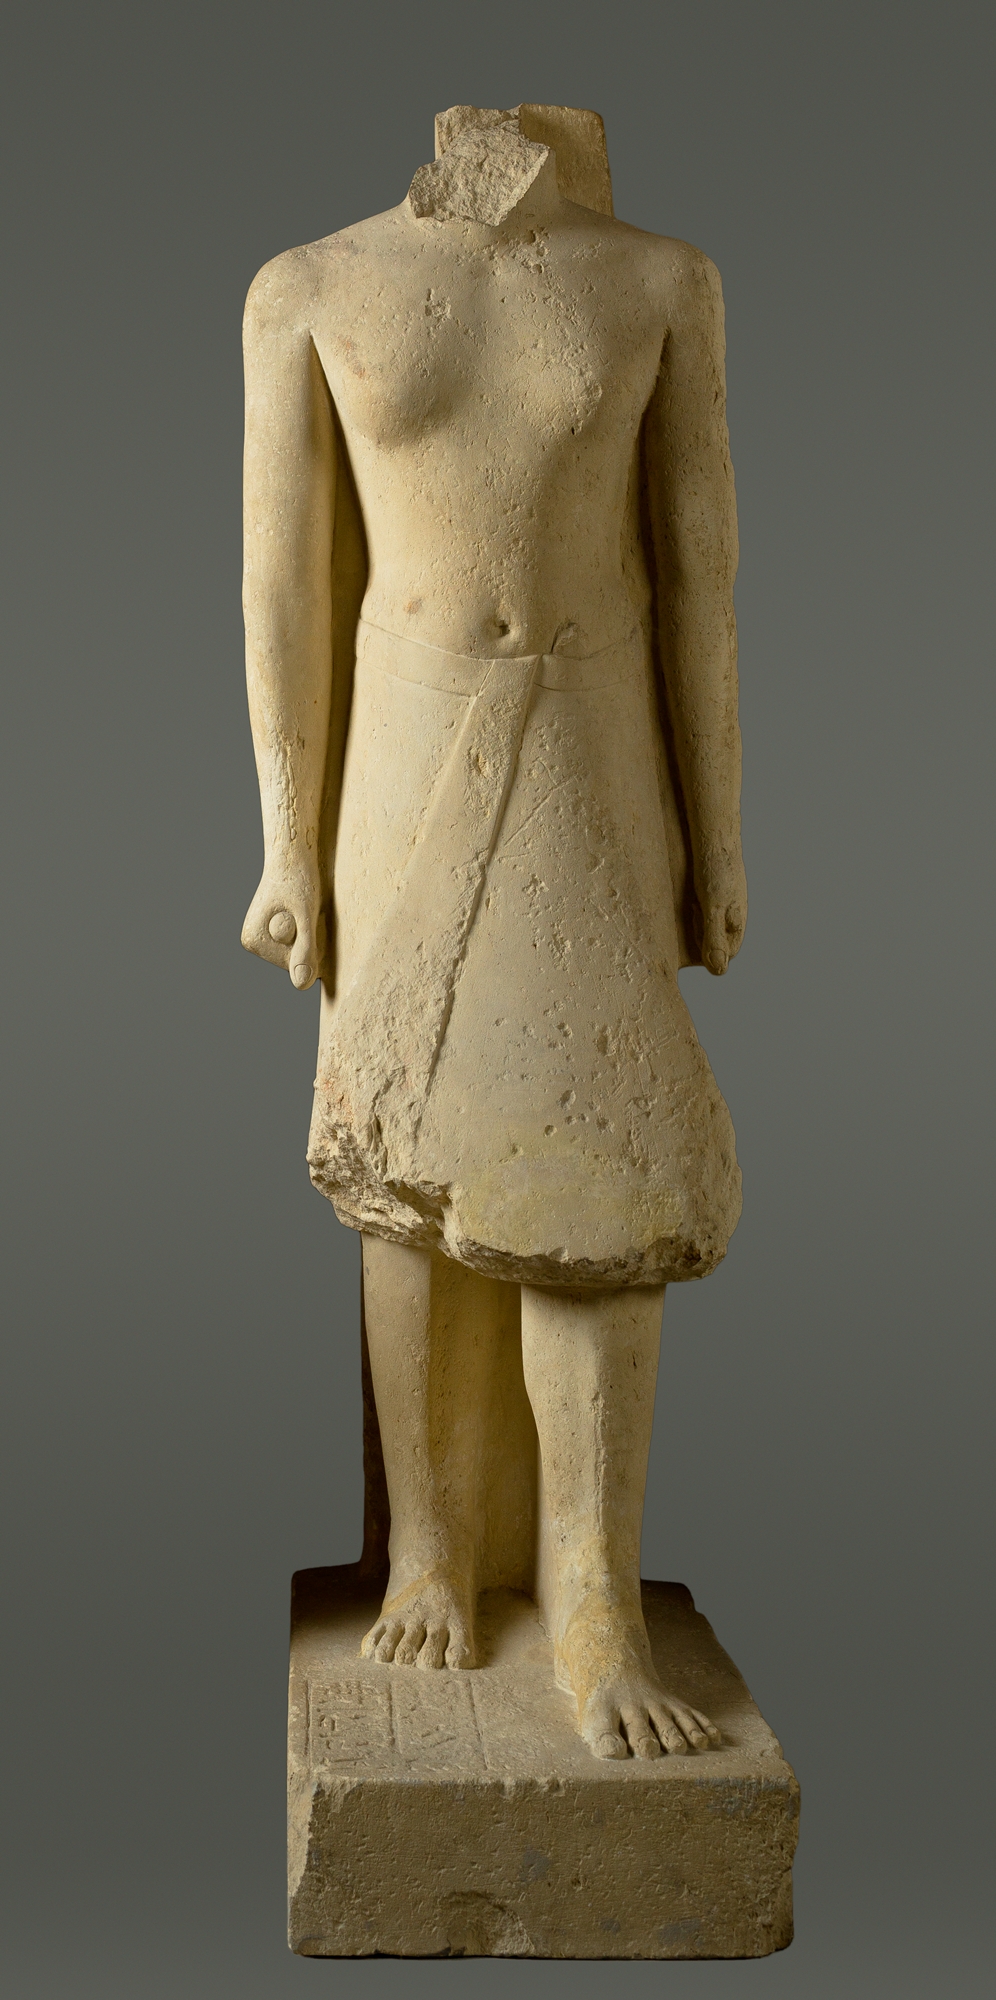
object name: statue, babaef a older man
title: Headless statue of Babaef as older man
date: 2475-2450 BCE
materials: limestone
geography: egypt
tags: men